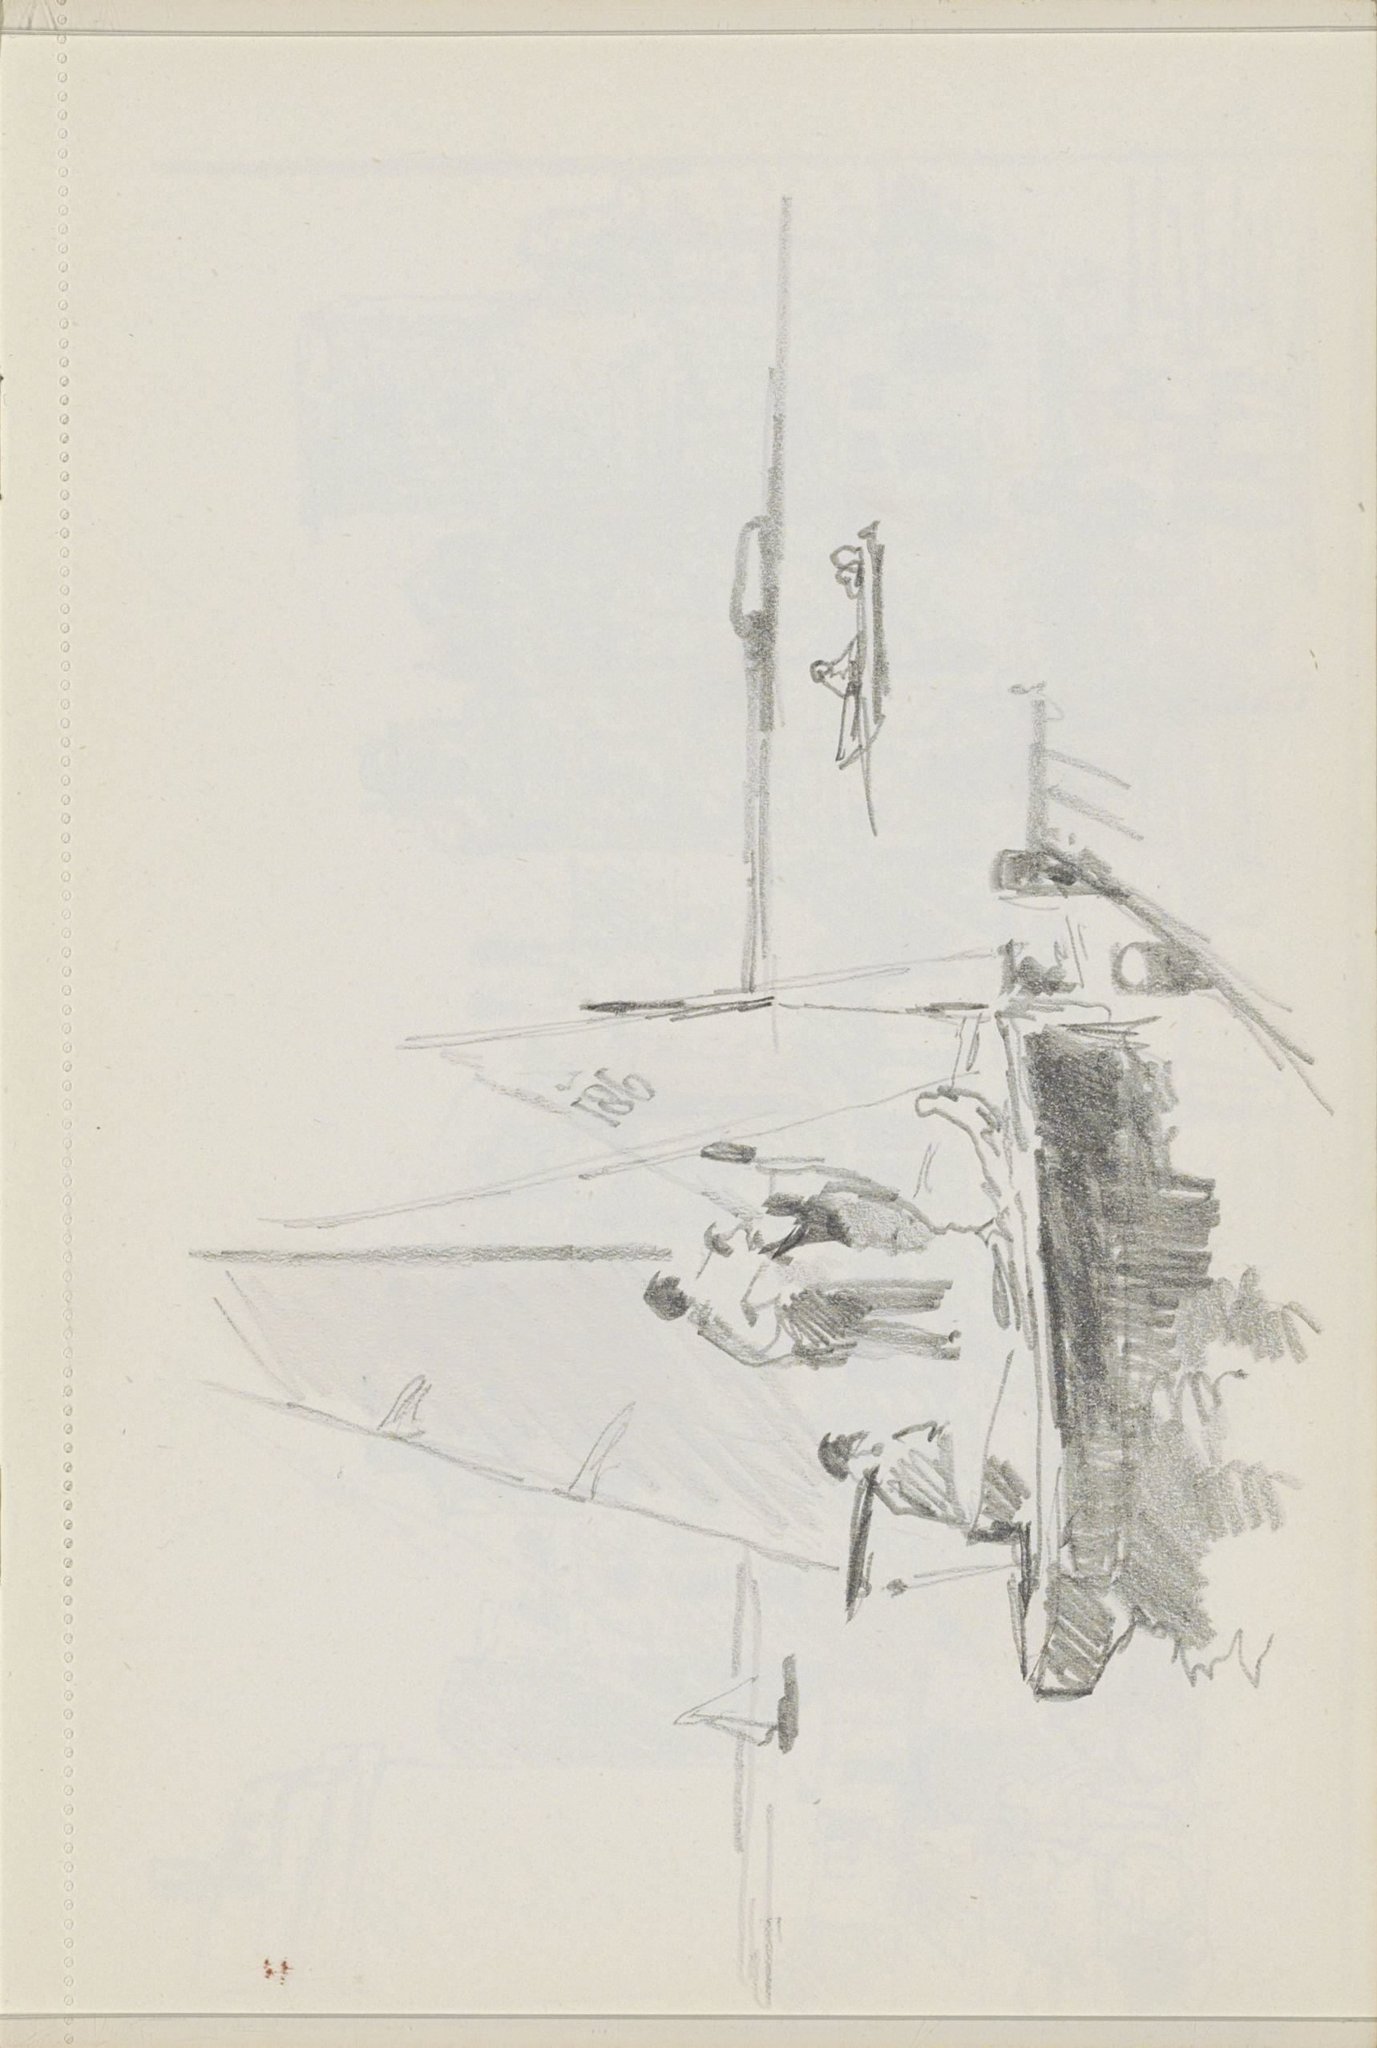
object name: sketchbook leaf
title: Figuren op een zeilboot bij een aanlegsteiger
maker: cornelis vreedenburgh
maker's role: draughtsman, print maker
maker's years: 1880-1946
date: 1890-1946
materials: paper, pencil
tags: sailing-ship, sailing-boat, landscapes with waters, waterscapes, seascapes (in the temperate zone)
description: Op de achtergrond een roei- en zeilboot op open water. Blad 27 recto uit een schetsboek met uit 75 bladen.